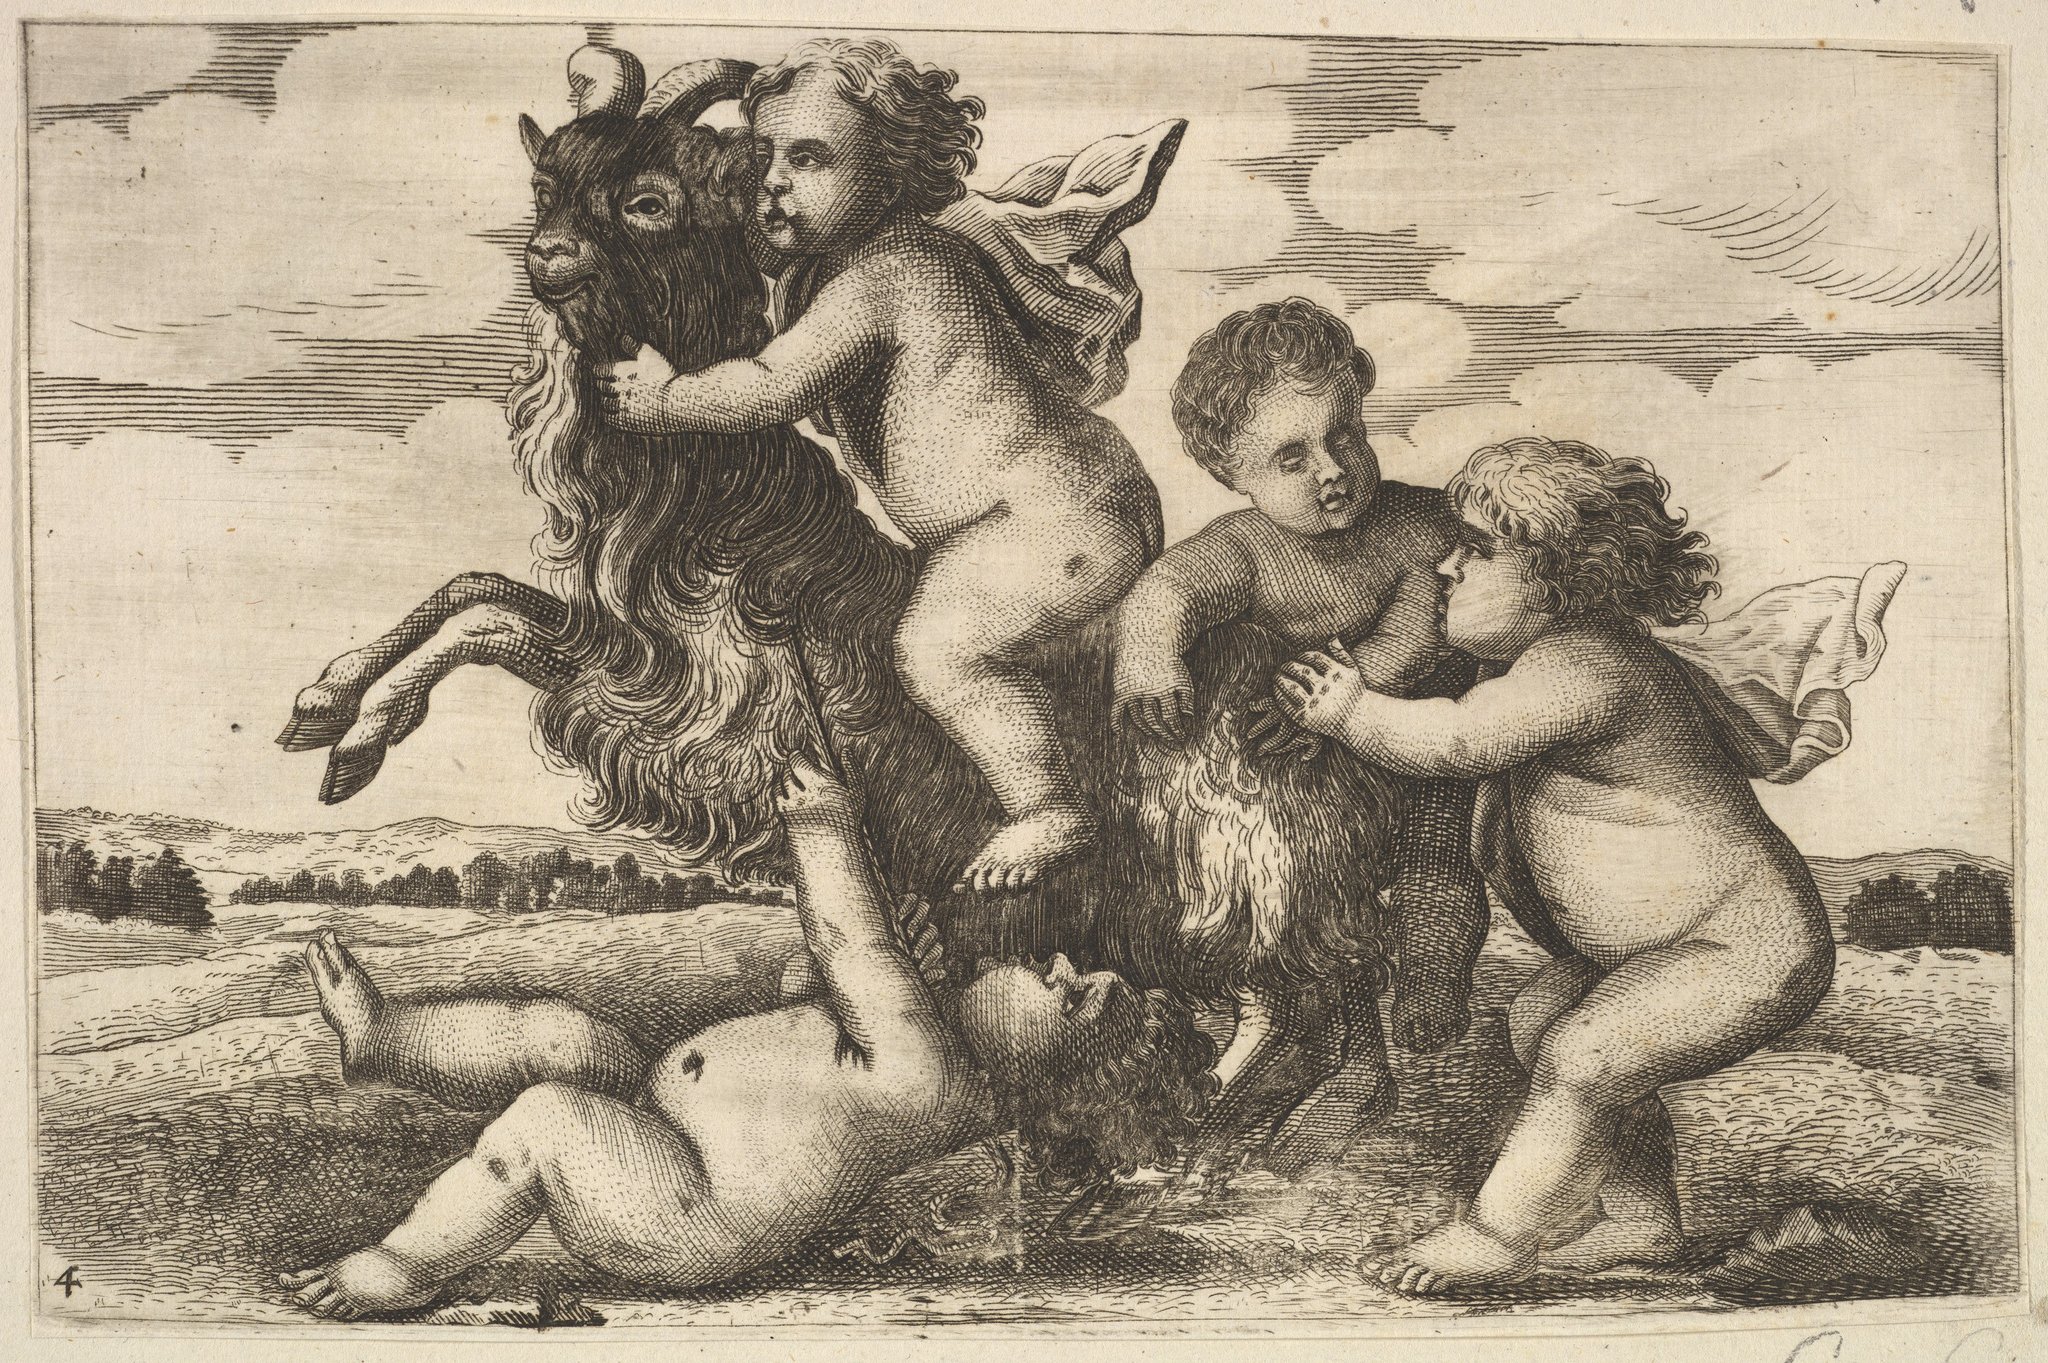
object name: print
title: Four small boys and a goat (copy in reverse)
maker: wenceslaus hollar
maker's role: artist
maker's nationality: bohemian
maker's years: 1607-1677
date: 1601-1700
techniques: etching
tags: boys,goats